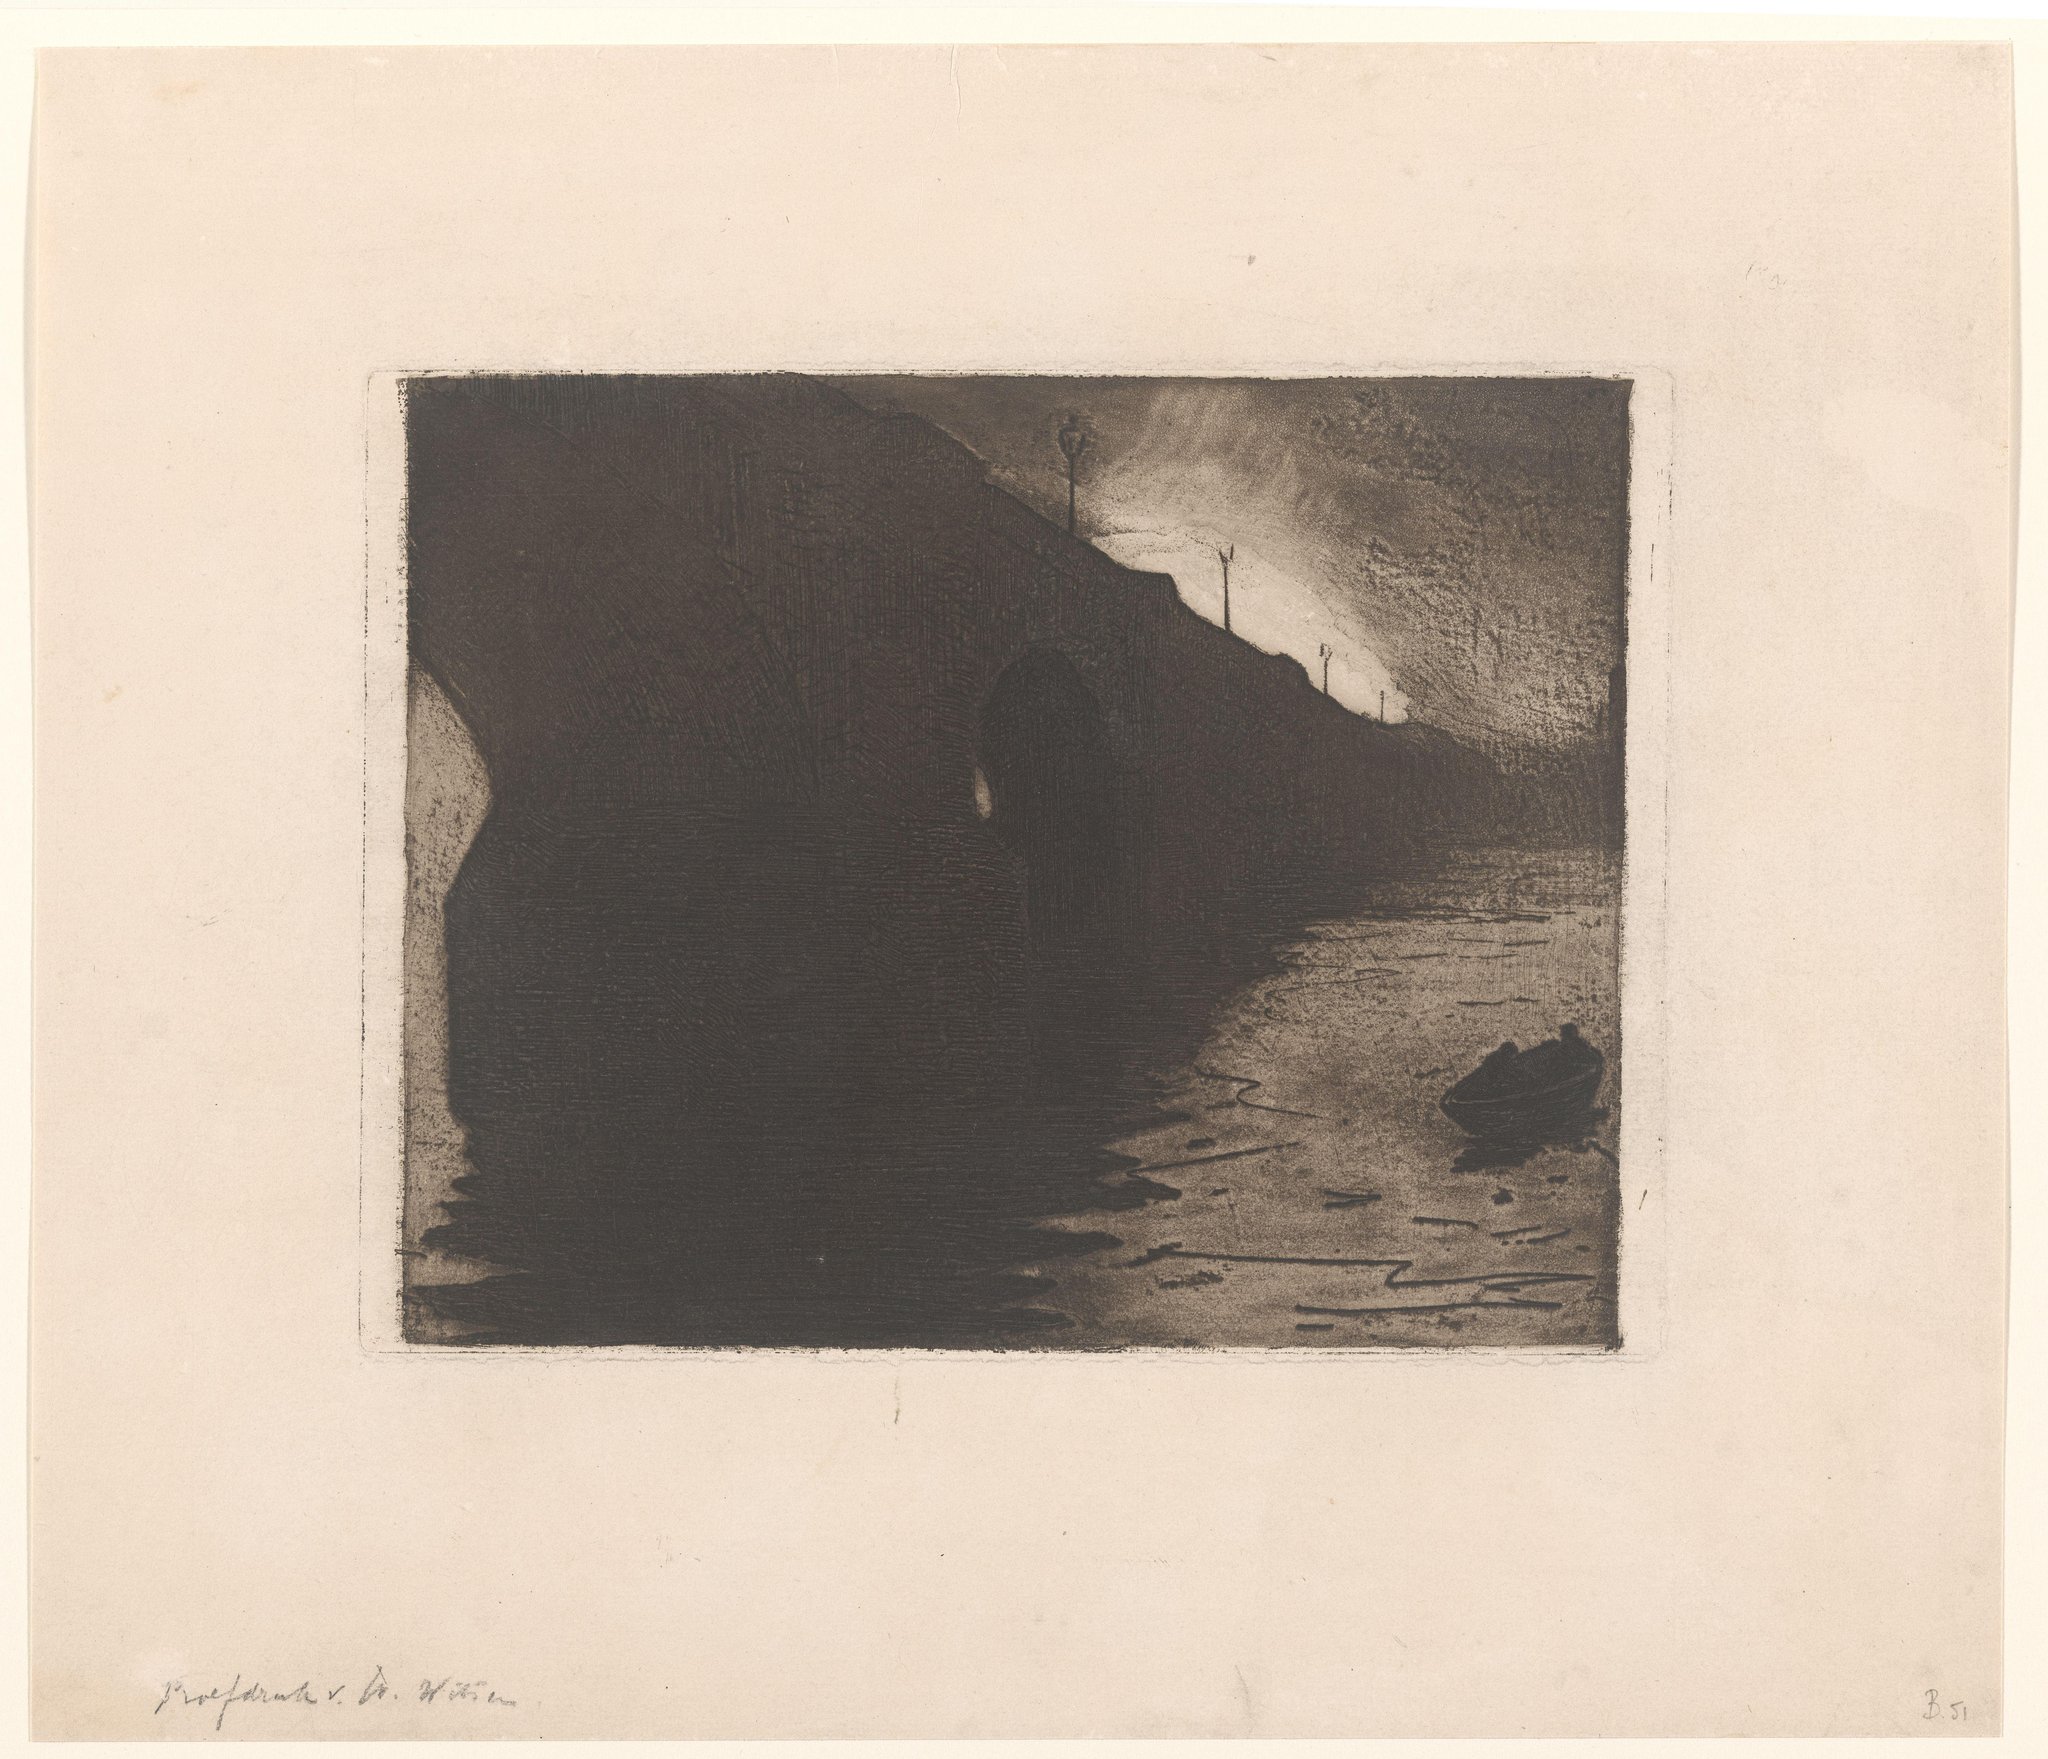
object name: print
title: Gezicht op Waterloo Bridge in de mist in Londen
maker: willem witsen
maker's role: draughtsman, painter, print maker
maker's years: 1860-1923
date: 1890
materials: paper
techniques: aquatint, etching, intaglio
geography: london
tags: rowing-boat, canoe, etc., bridge in city across river, canal, etc.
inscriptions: inscription: ‘proefdruk v. W. Witsen’, collector's mark: Lugt 2228, watermark